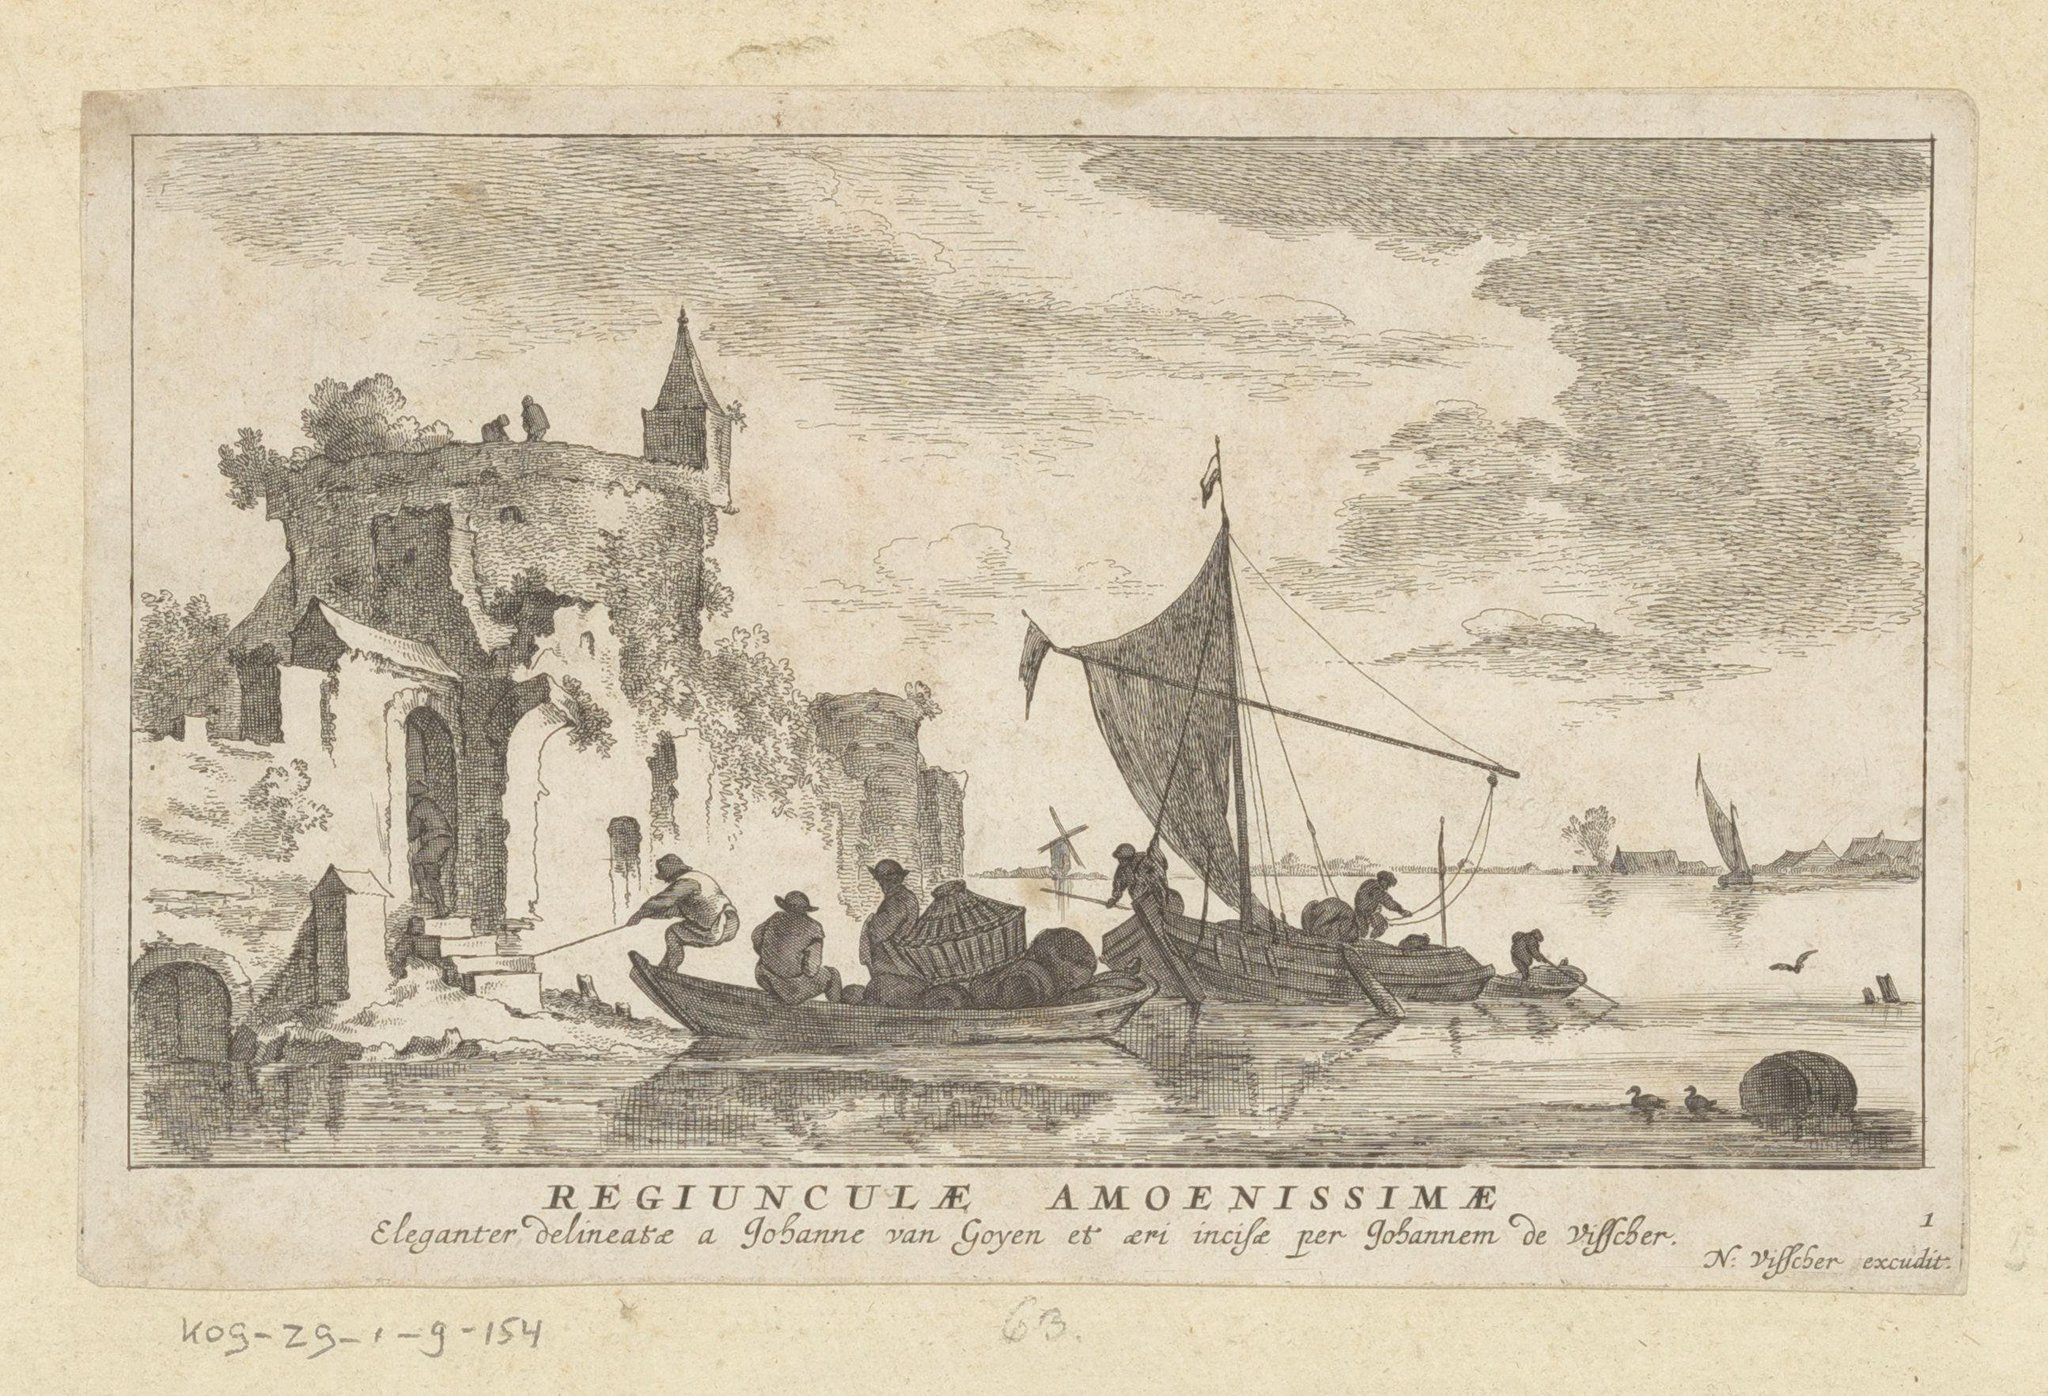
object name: titelprent, frontispice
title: Landschappen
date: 1682-1709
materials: paper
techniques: engraving, etching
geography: amsterdam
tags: sailing-ship, sailing-boat, landscapes, river, landscape with ruins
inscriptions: collector's mark: Lugt 1641, stamp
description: Titelprent voor een serie met landschappen naar Jan van Goyen, met een gezicht op een rivier. Op de voorgrond twee boten die bij een ruïne aan proberen te leggen. Rechtsonder genummerd: 1. Onderwerpsrubrieken binnen de Atlas Zeden en Gewoonten: Handel, nijverheid en verkeer, Buitenleven.